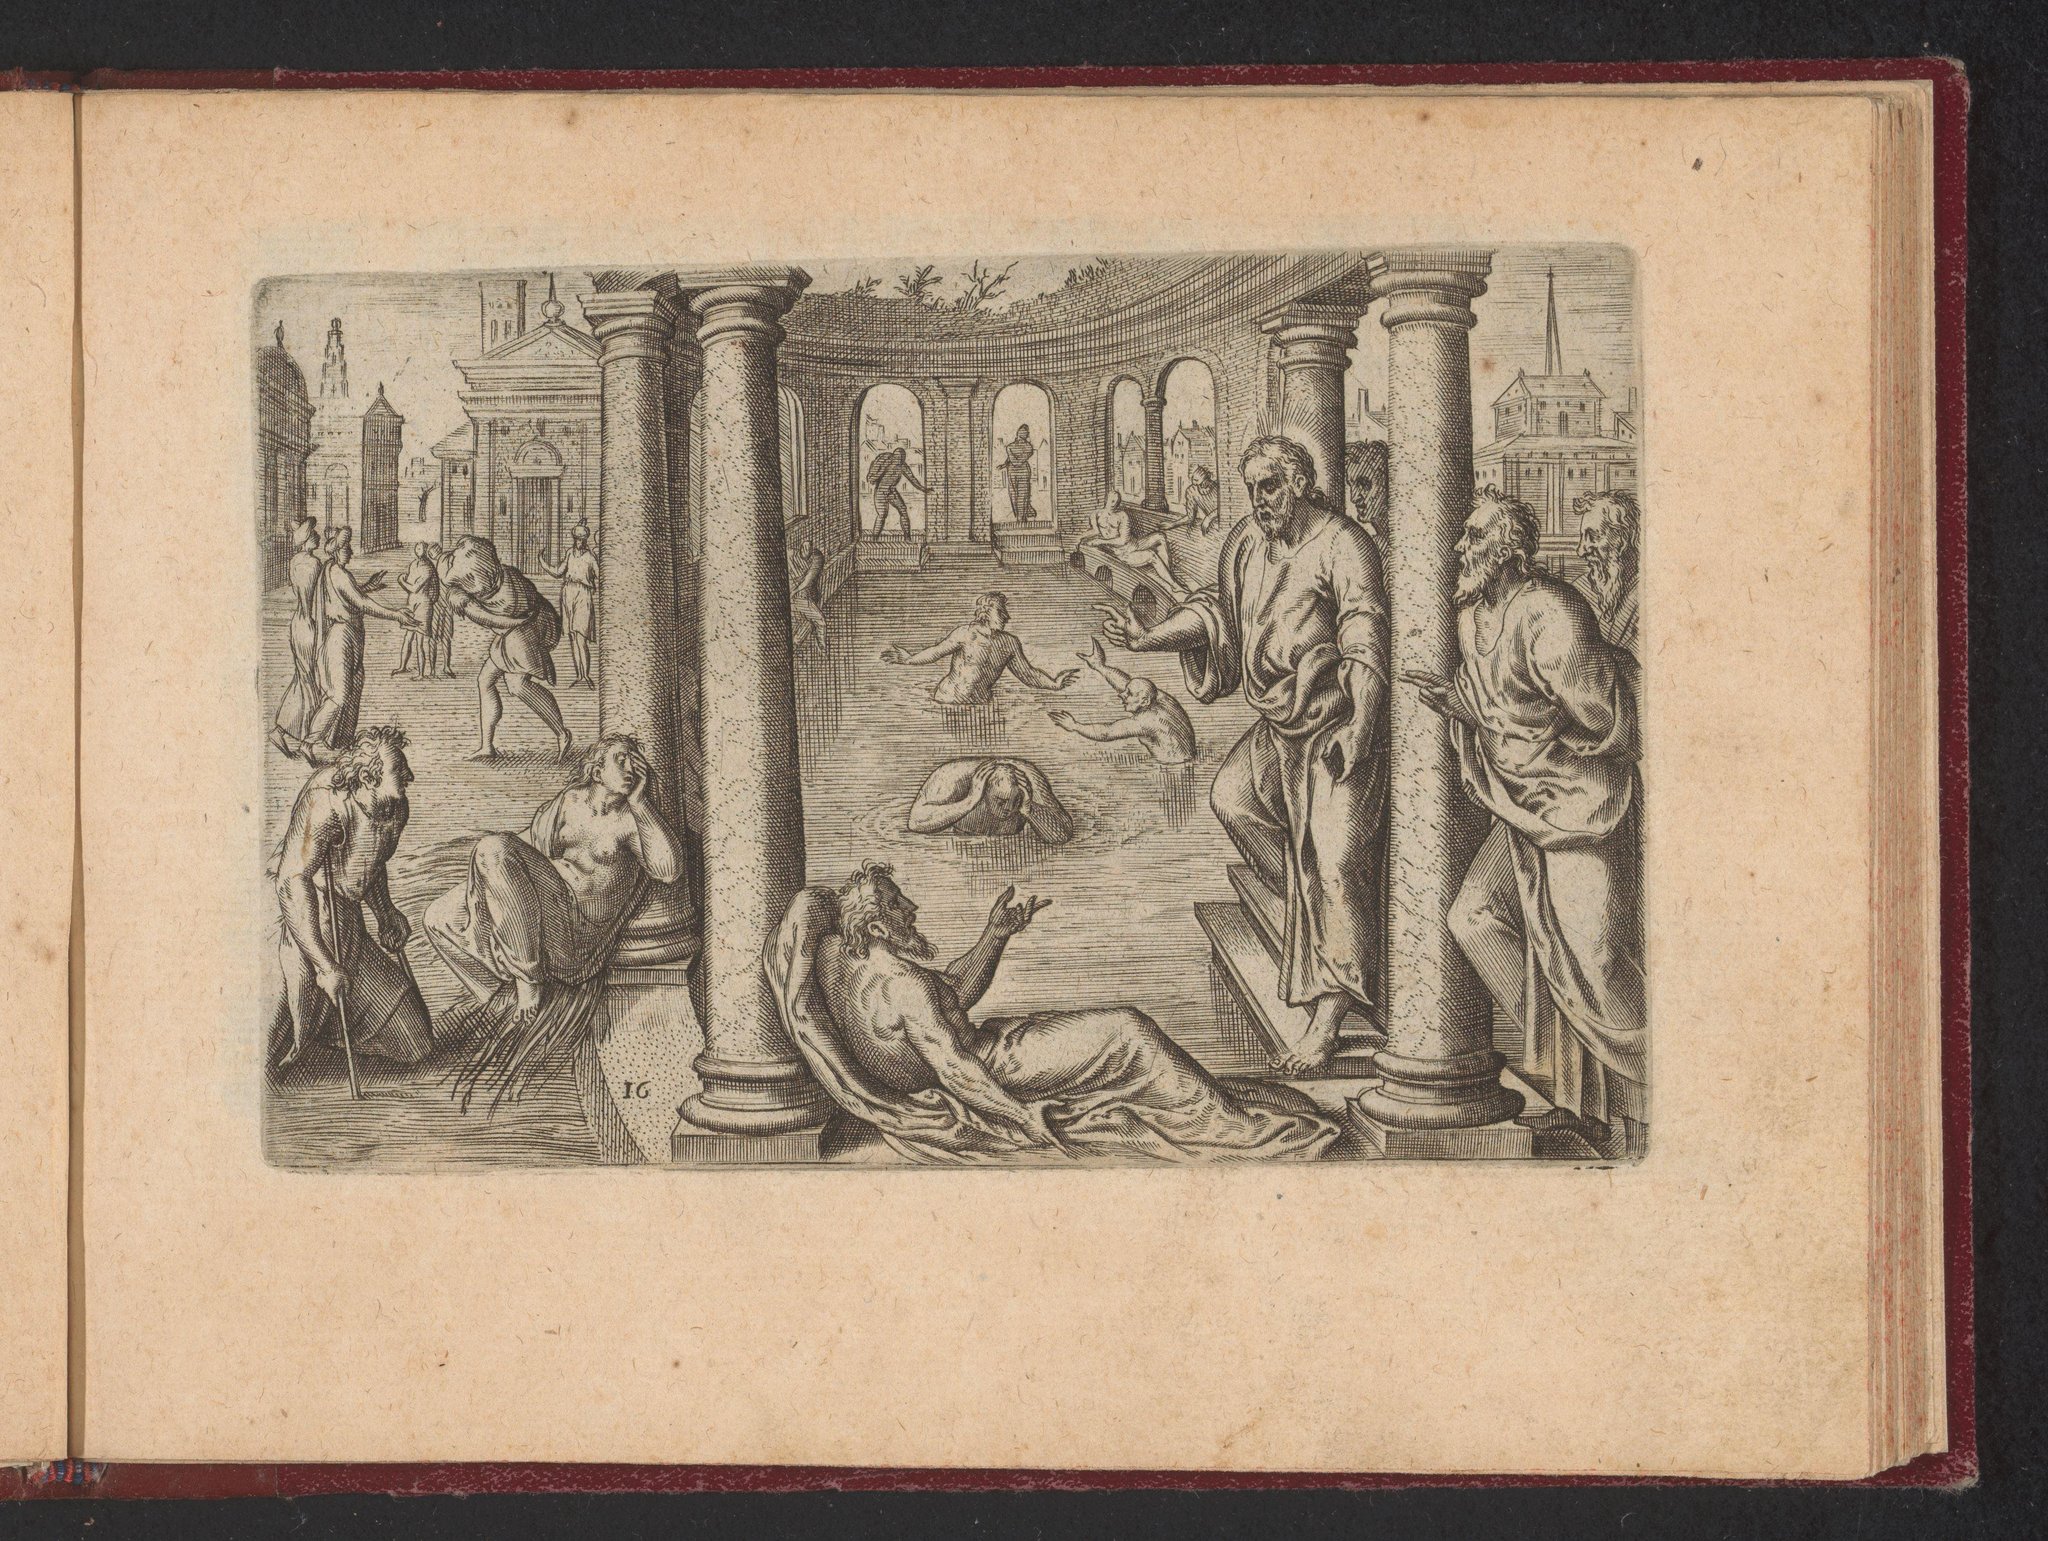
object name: print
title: Christi Iesu vitae admirabiliumque actionum speculum a Philippo Gallaeo apparatum Bened. Ariae Montani singuloribus distichis instructum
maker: philips galle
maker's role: print maker, publisher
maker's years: 1537-1612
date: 1573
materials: paper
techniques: engraving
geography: antwerp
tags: christ says to a paralytic man: 'rise, take up your pallet (bed)'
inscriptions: watermark: ‘gotische letter P’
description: Onderdeel van een album met een titelprent en een serie van 50 prenten betreffende het leven en de passie van Christus.